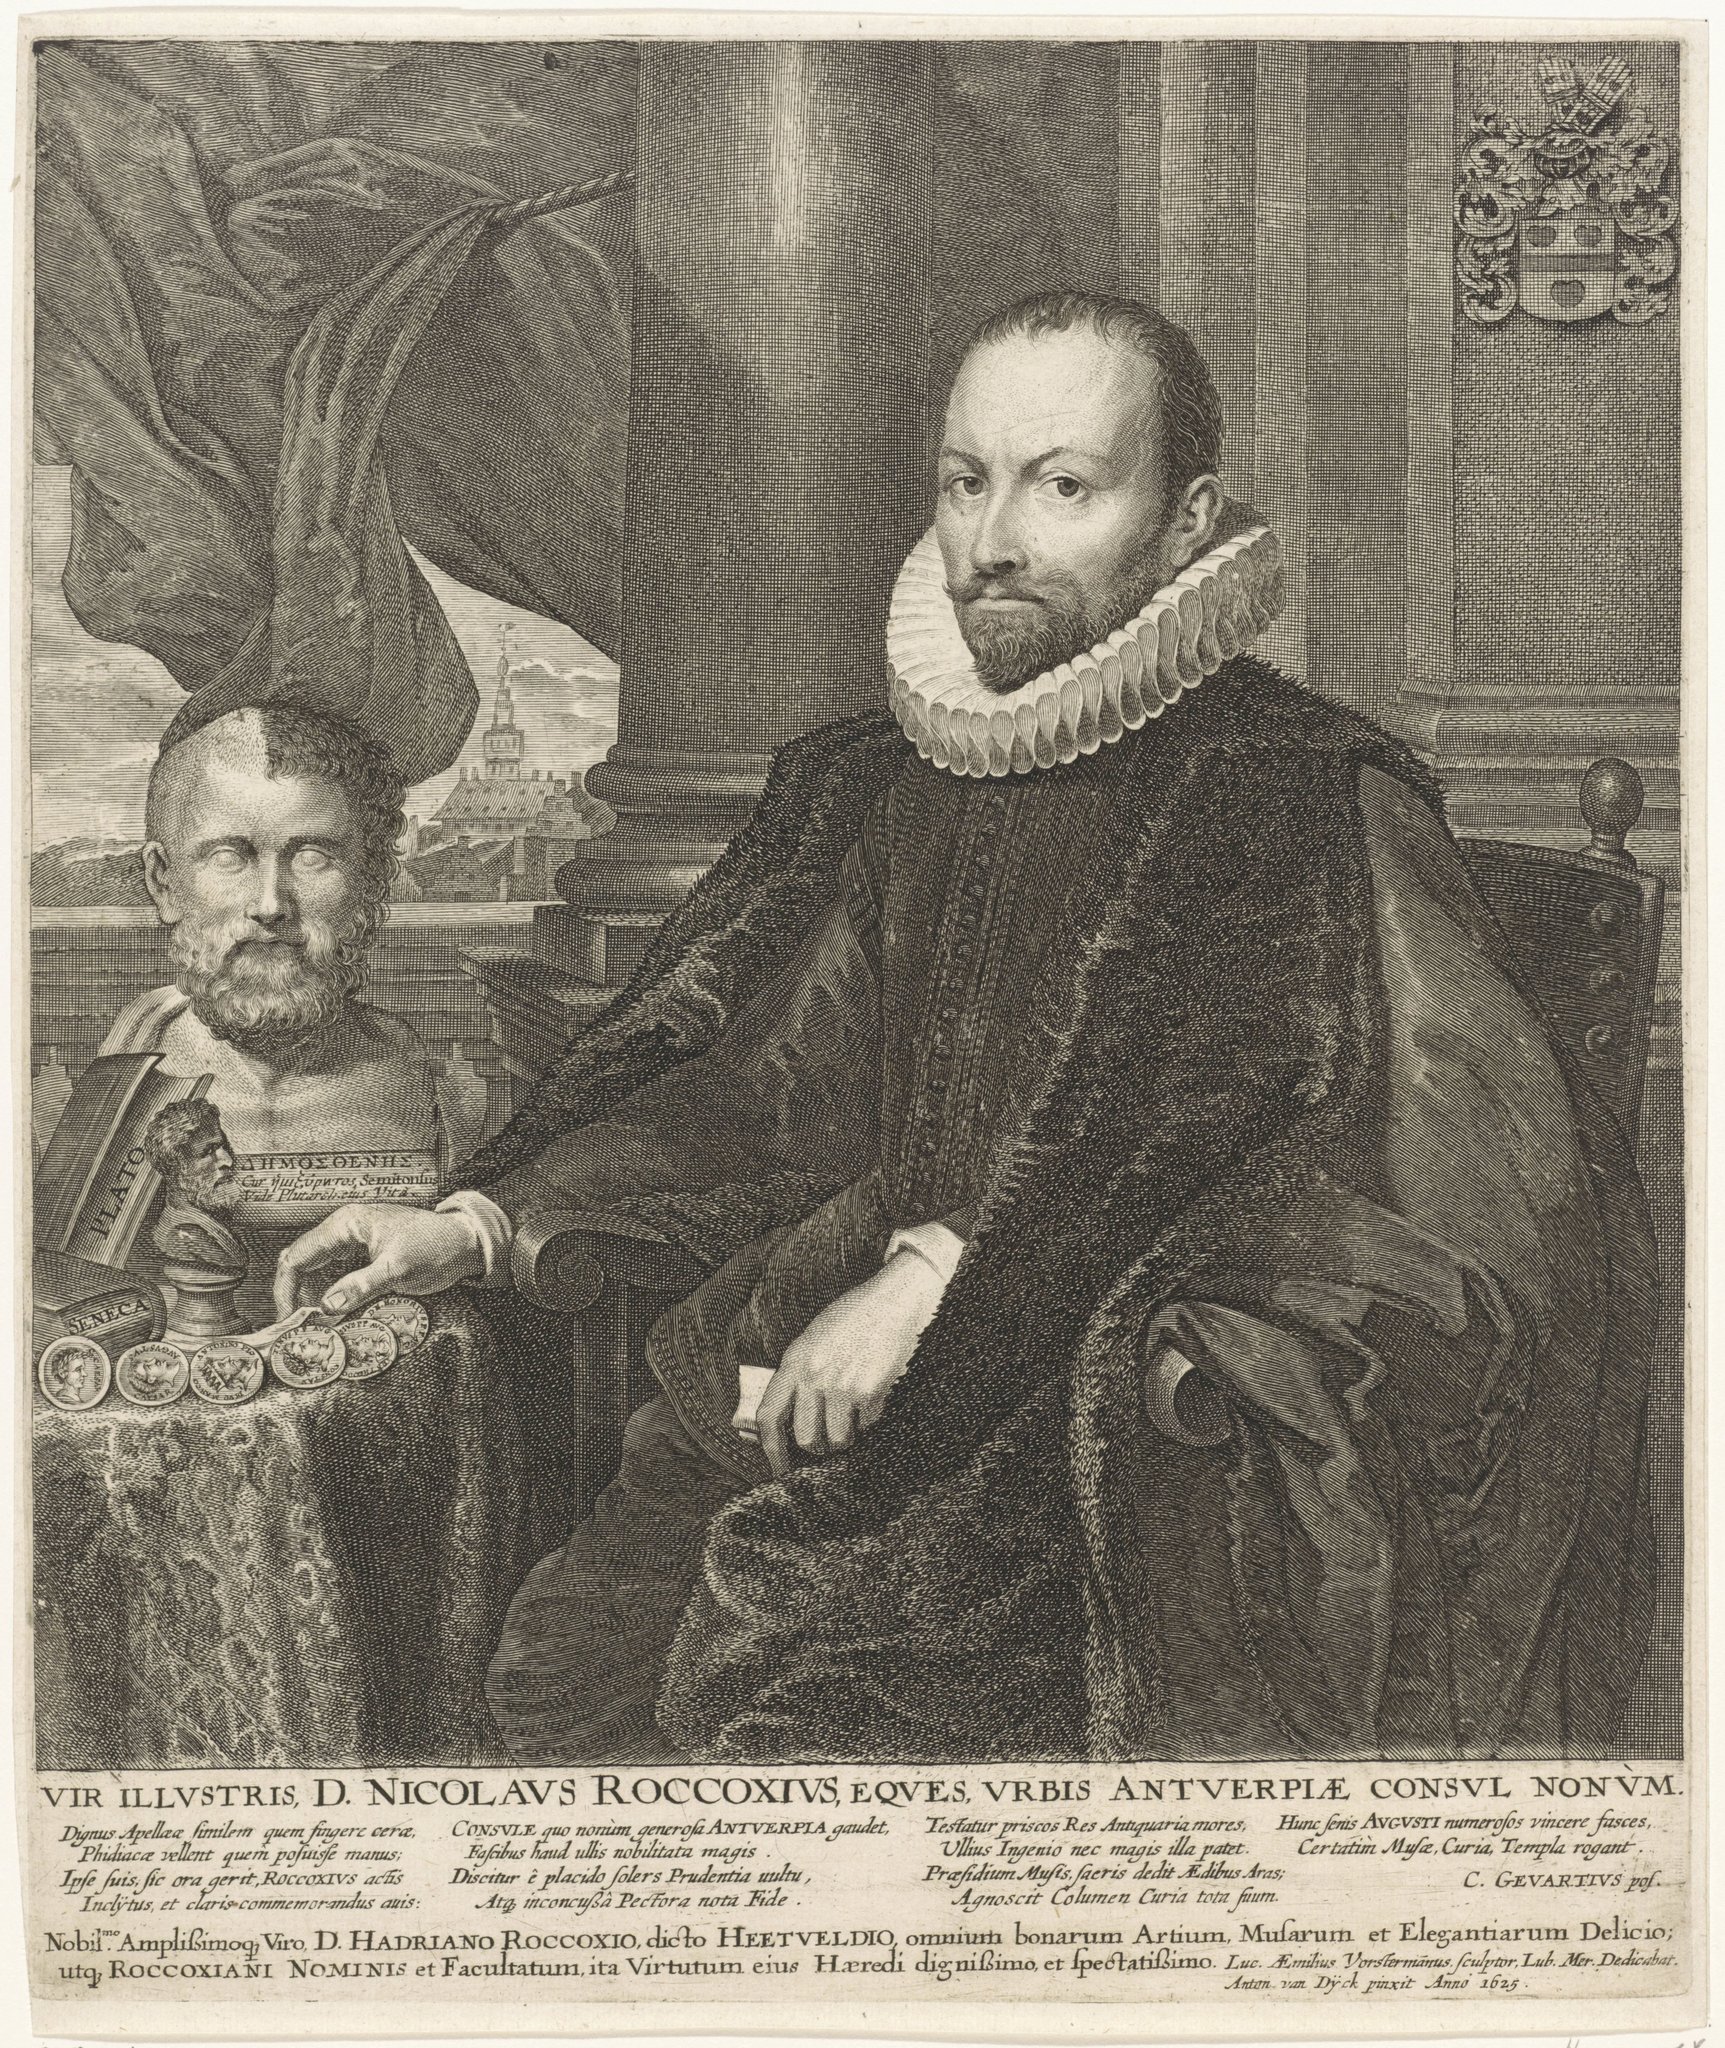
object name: print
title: Portret van Nikolaas Rockox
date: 1625-1666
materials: paper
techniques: engraving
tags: antwerp, mayor, nikolaas rockox, (story of) demosthenes - portrait of person from classical history (+ full face)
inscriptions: collector's mark: Lugt 2228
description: Portret van Nikolaas Rockox, burgemeester van Antwerpen en kunstliefhebber. Hij zit in een interieur met voor hem op tafel boeken en kunstvoorwerpen, waaronder een buste van de Griekse redenaar en politicus Demosthenes.